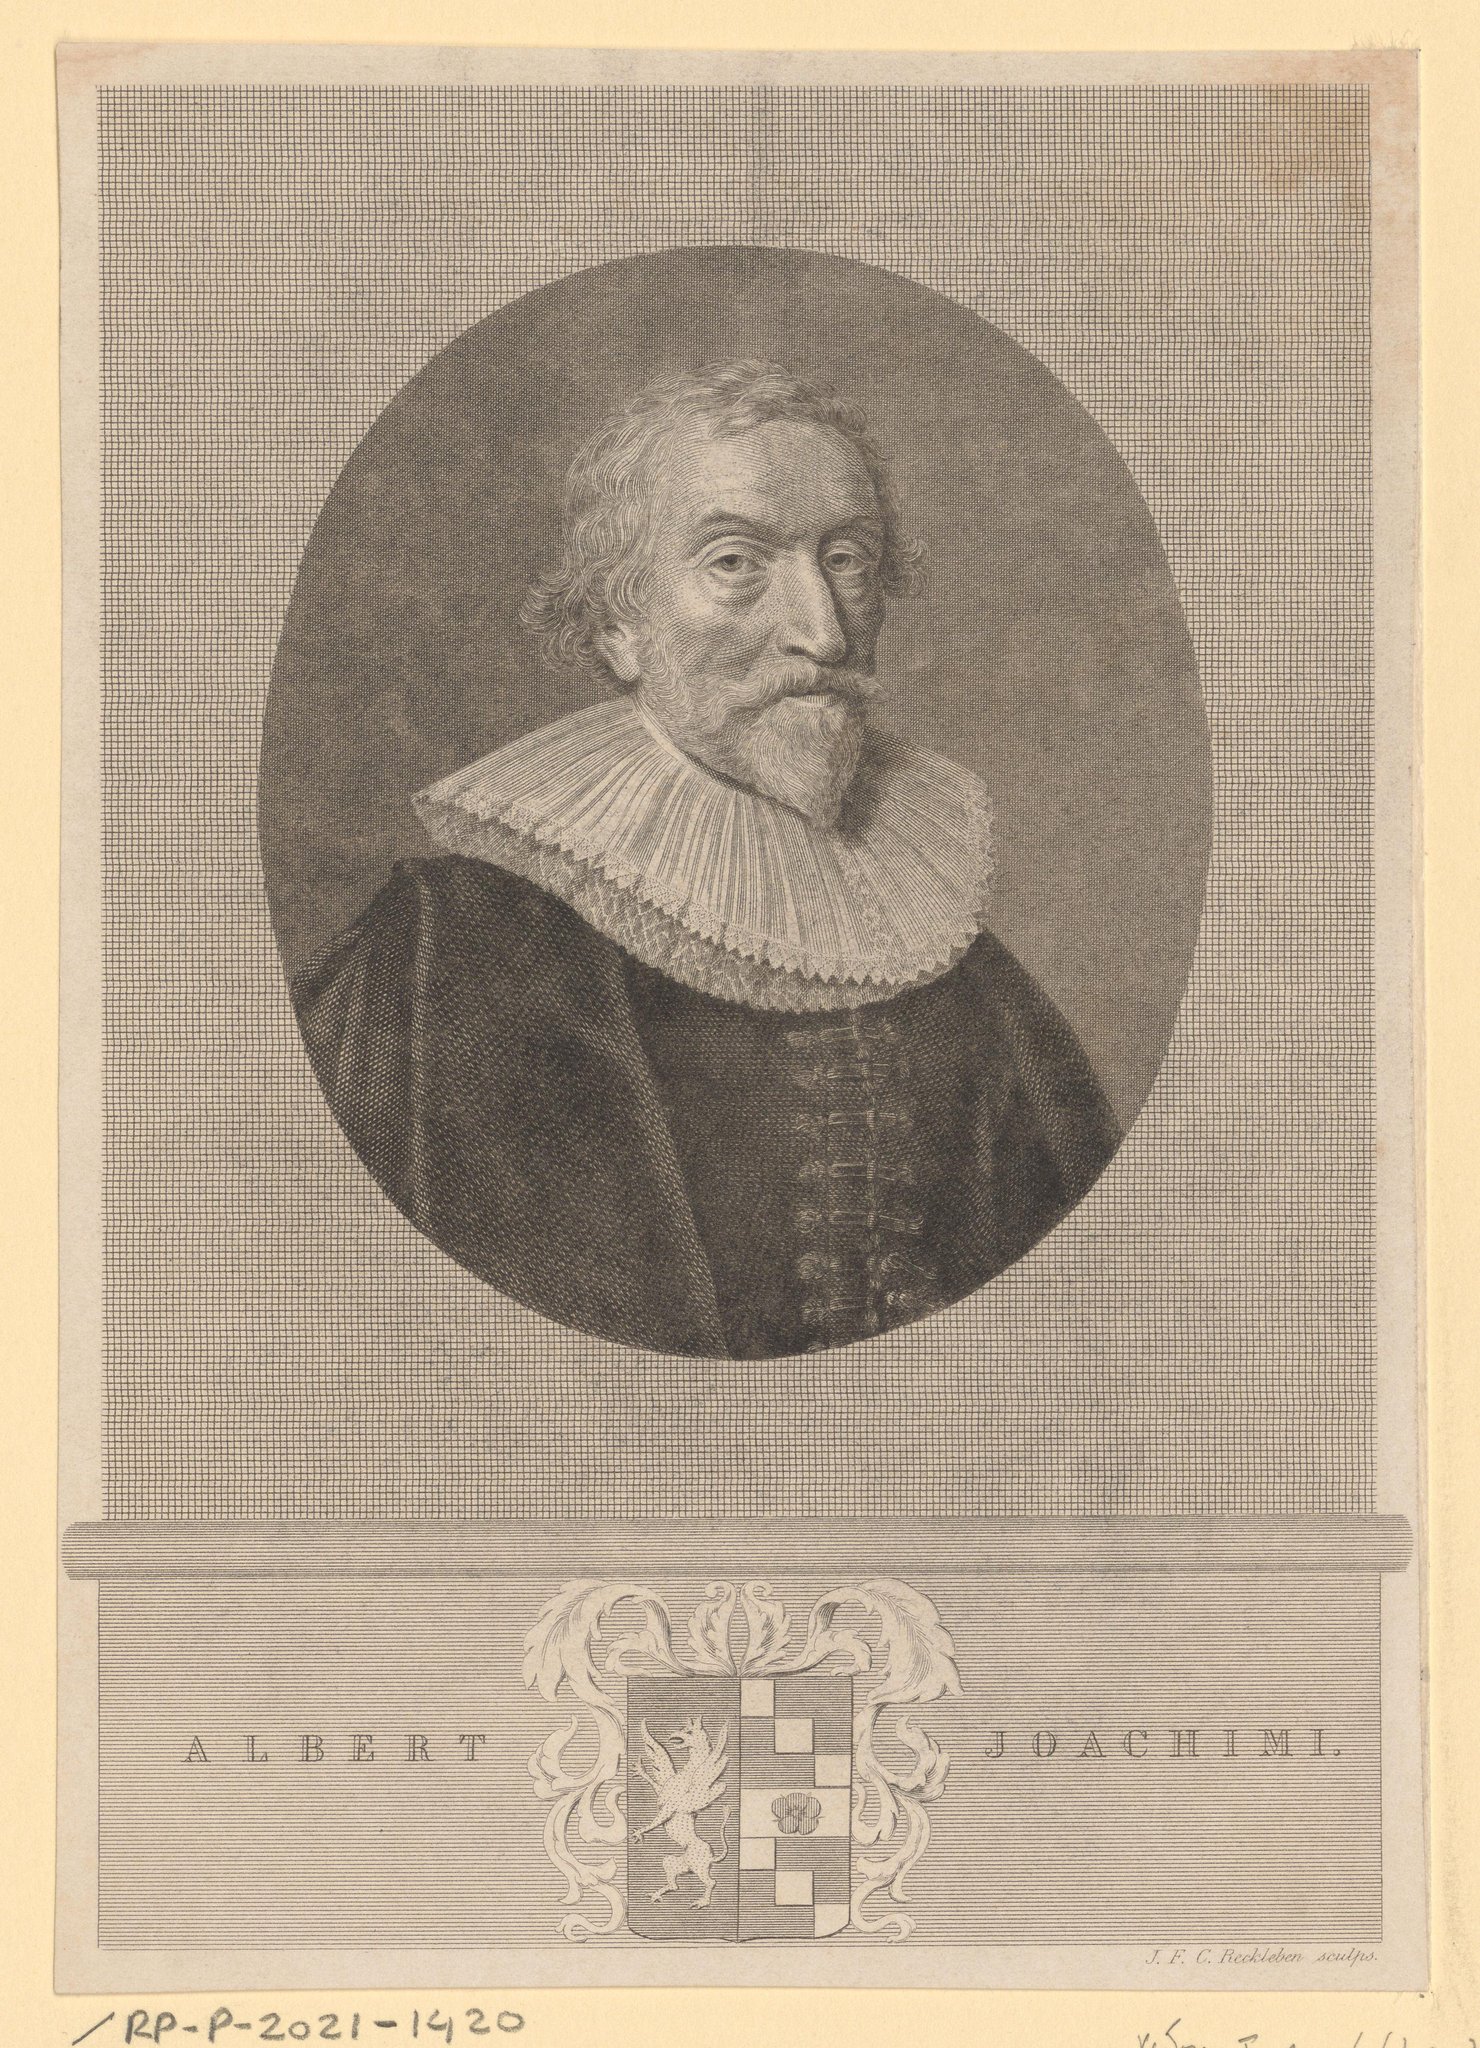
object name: print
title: Portret van Albert Joachimi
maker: jan frederik christiaan reckleben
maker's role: print maker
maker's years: 1819-1879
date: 1860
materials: paper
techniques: engraving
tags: historical persons, municipal government, armorial bearing, heraldry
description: Prent mogelijk uit: Arend, Johannes Pieter. Algemeene geschiedenis des vaderlands van de vroegste tijden tot op heden. Amsterdam: C.L. Schleijer & zoon, 1860, dl. 3-3.